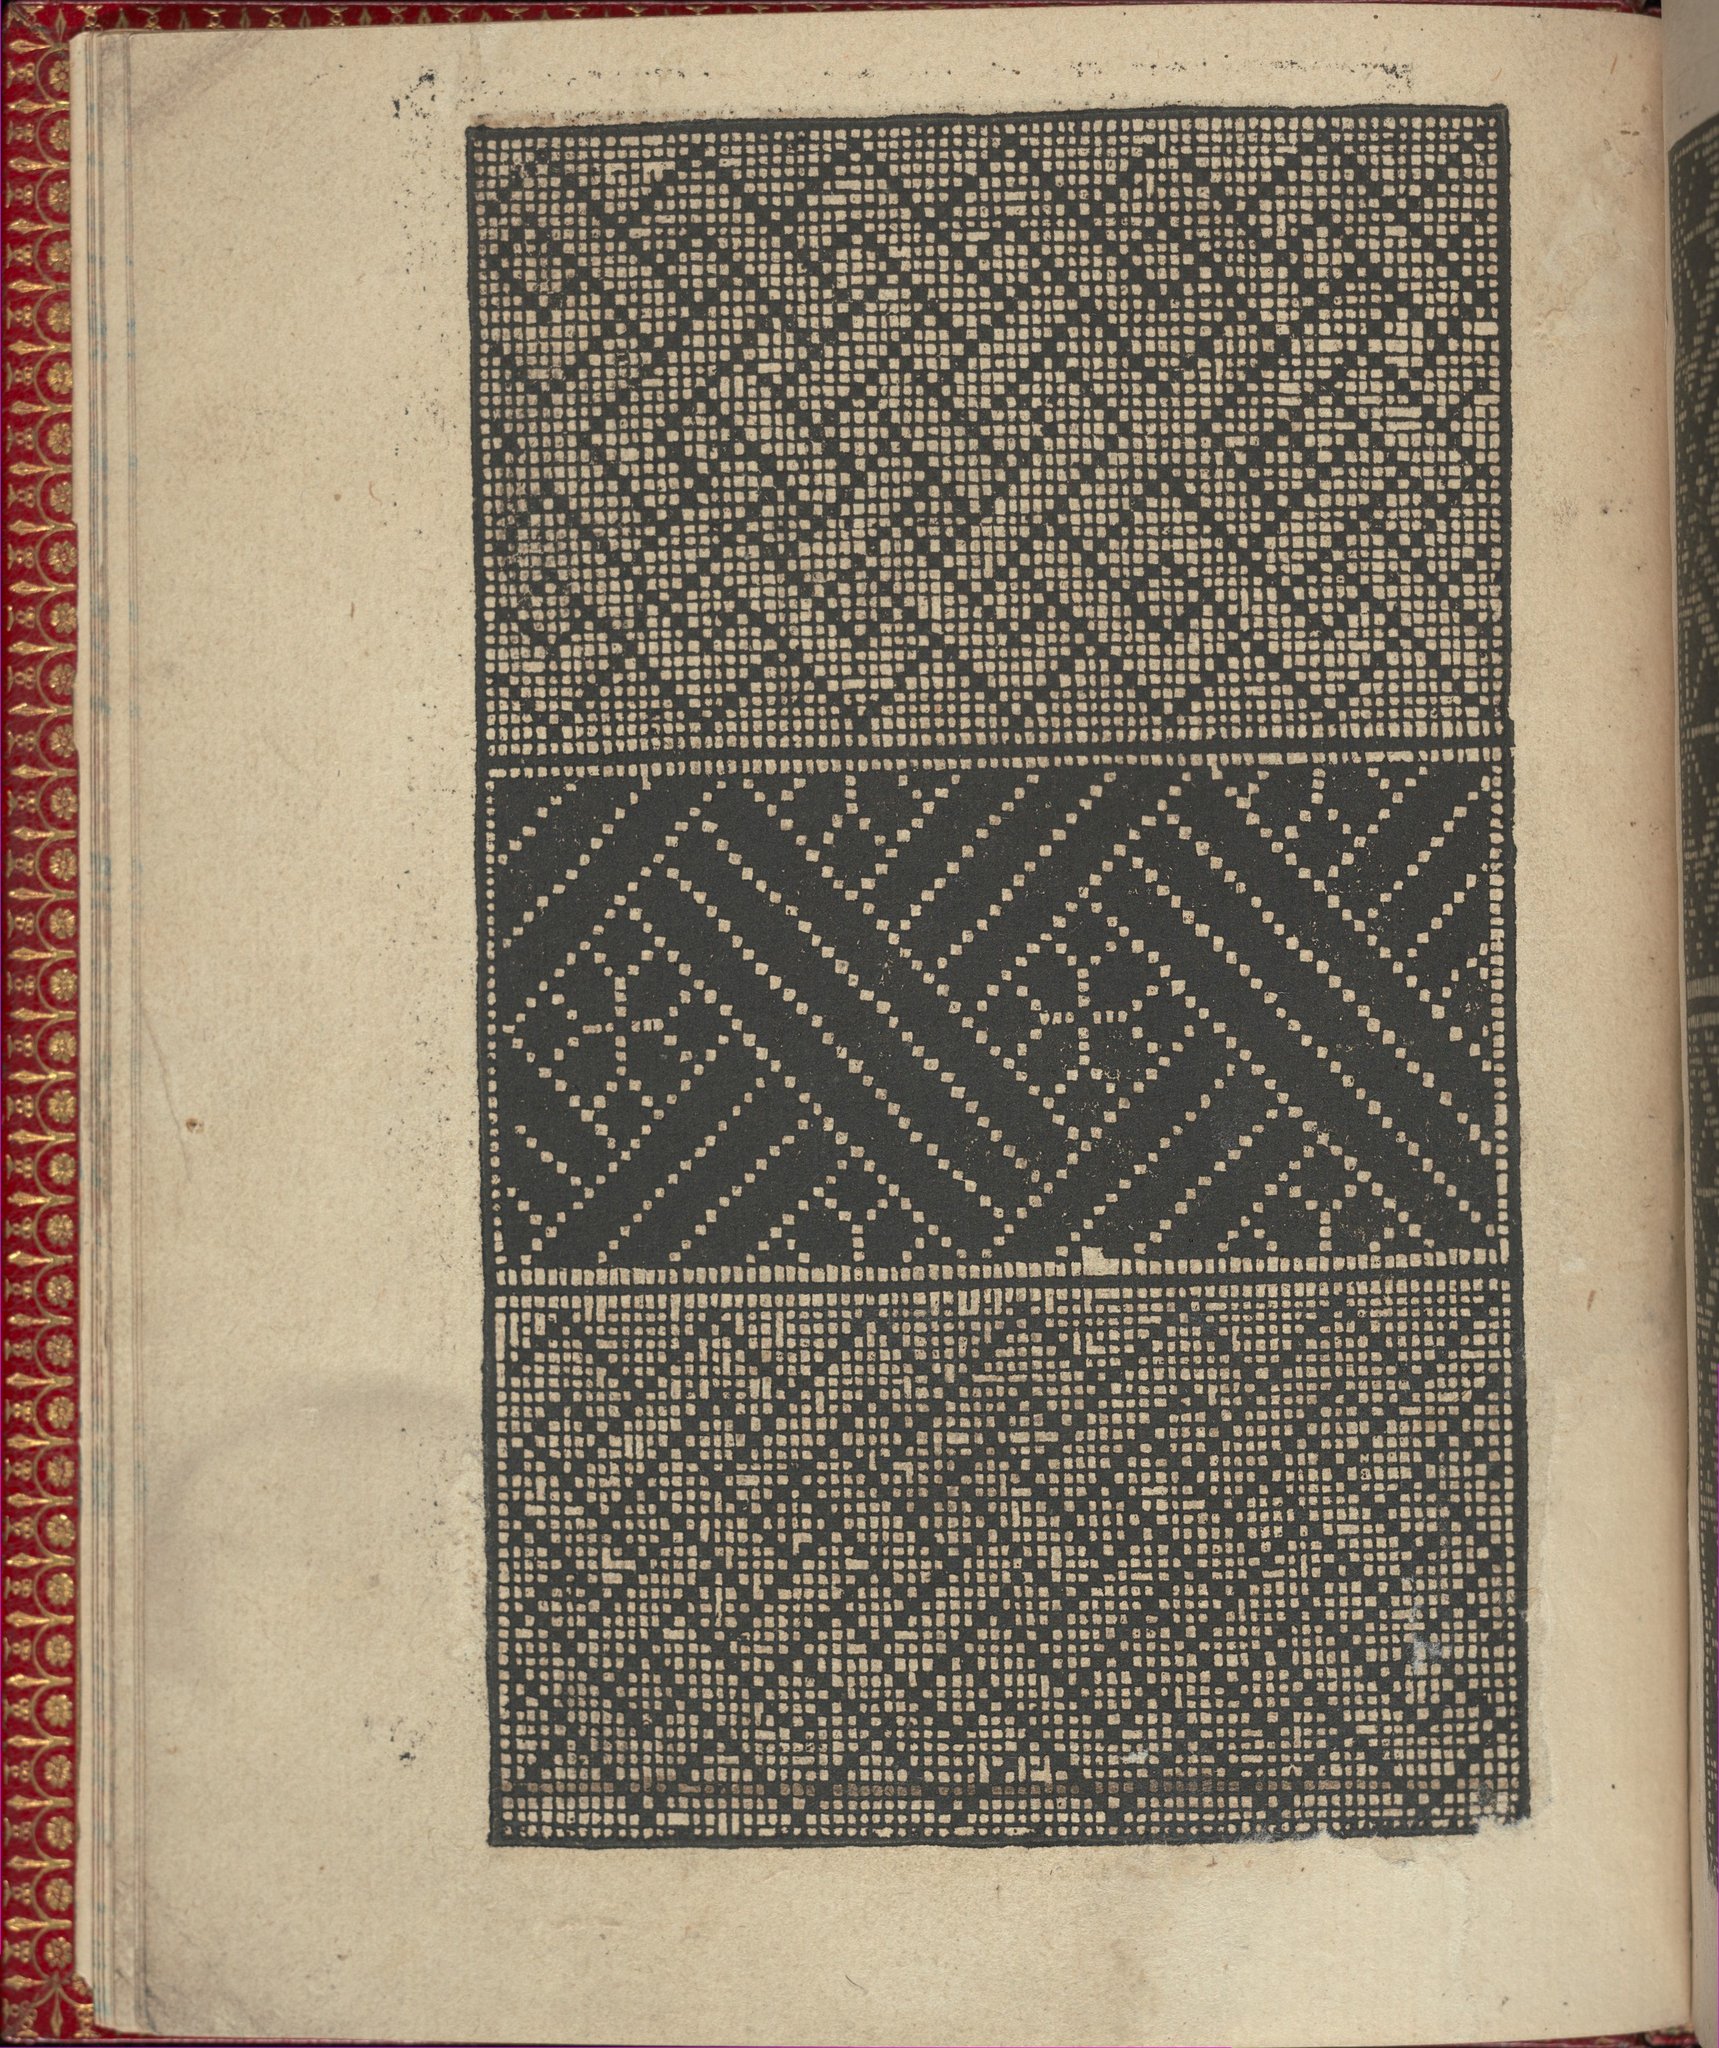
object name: book print ornament architecture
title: Ce est ung tractat de la noble art de leguille ascavoir ouvraiges de spaigne... page 5 (recto)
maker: willem vosterman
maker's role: printer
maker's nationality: netherlandish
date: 1527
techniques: woodcut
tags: ornament